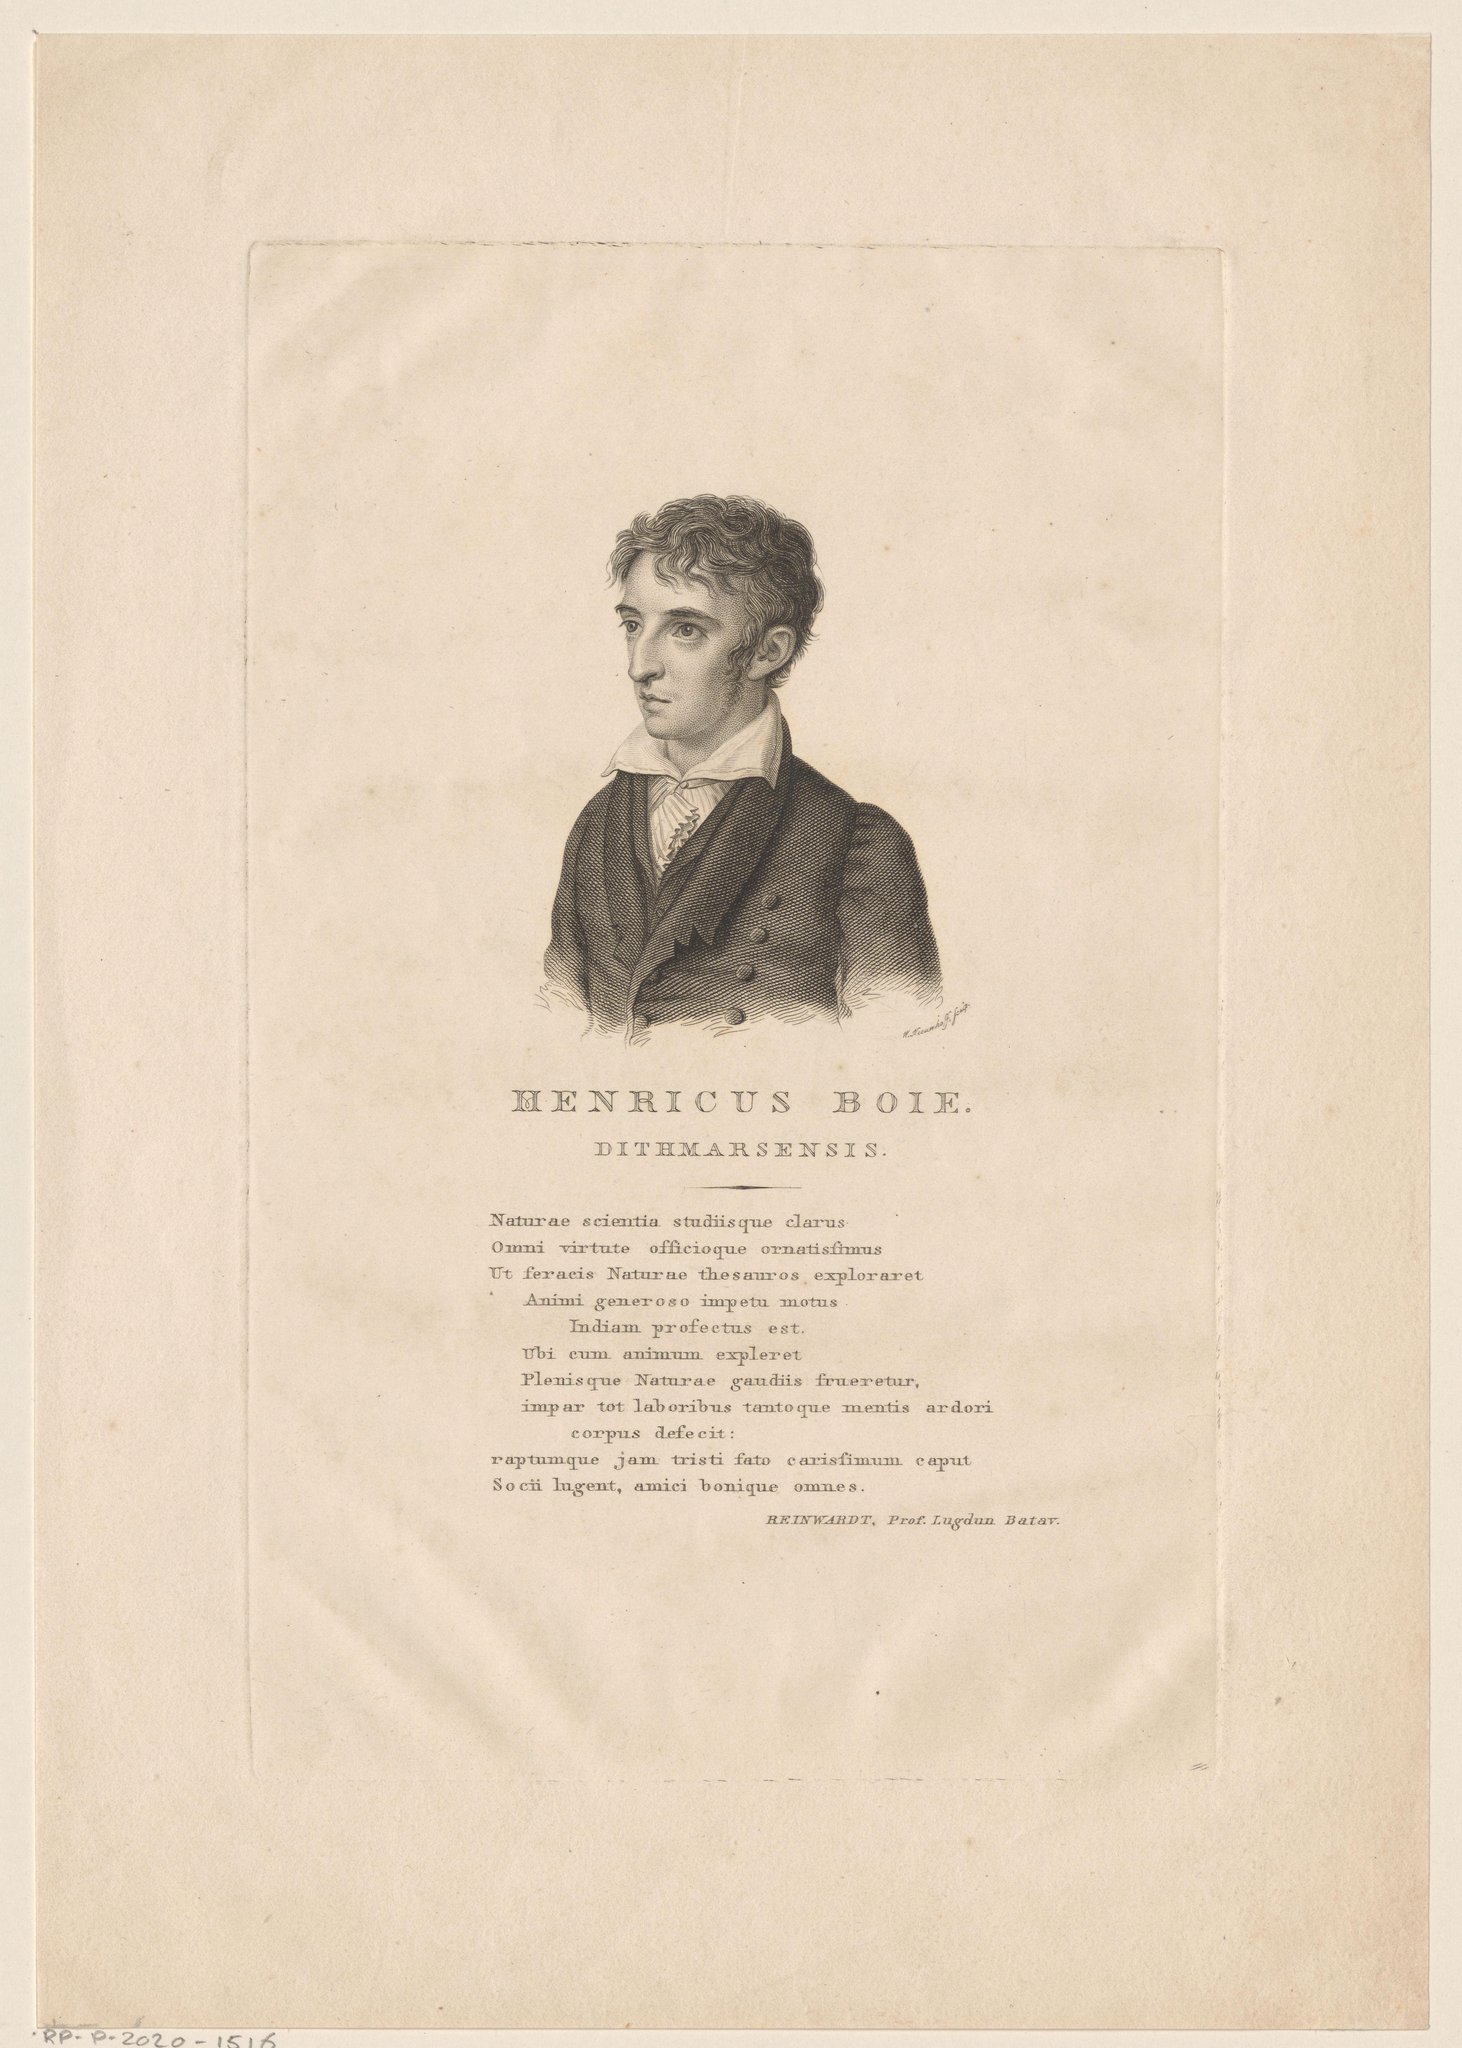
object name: print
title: Portret van Heinrich Boie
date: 1834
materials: paper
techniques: engraving, etching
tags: historical persons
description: Prent mogelijk uit: Susanna, J.A. Levensschets van Hendrik Boie en hulde aan zijne deugden en verdiensten (...). Amsterdam: Pieter Meyer Warners, 1834.